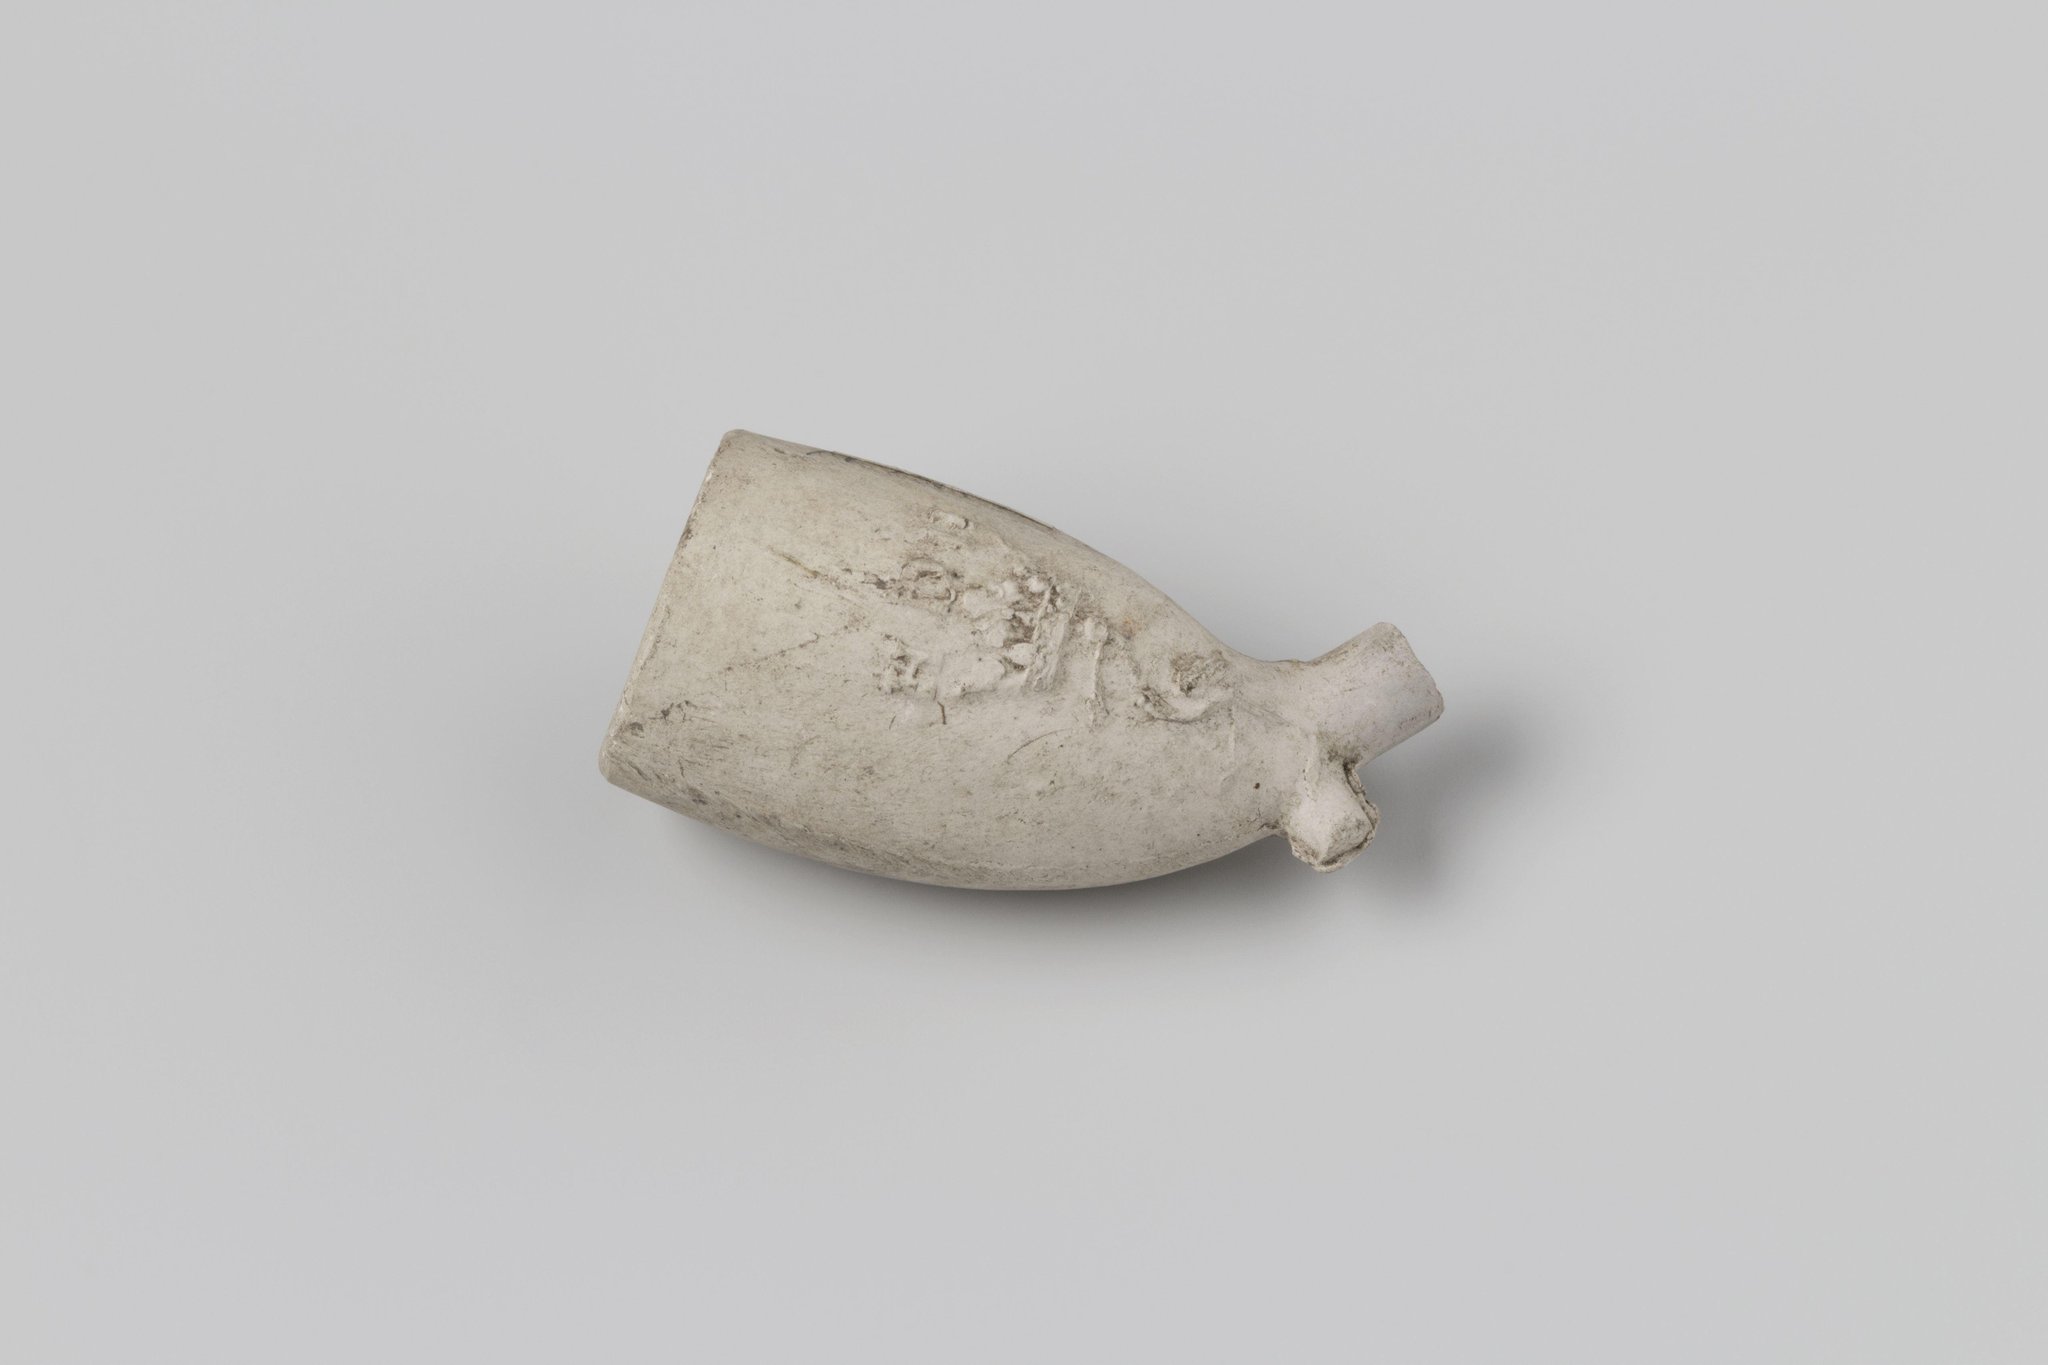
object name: pipe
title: Fragment pijpenkop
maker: huijbert de hoog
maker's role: pijpenfabrikant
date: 1750-1800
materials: clay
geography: schoonhoven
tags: the hague, shore-birds and wading-birds: stork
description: Fragment pijpenkop met een kroon en een ooievaar en de letters H D H afgebeeld. Van de opgravingen op de Hofstede Arentsburg 1827-1831 onder toezicht van Professor Reuvens.